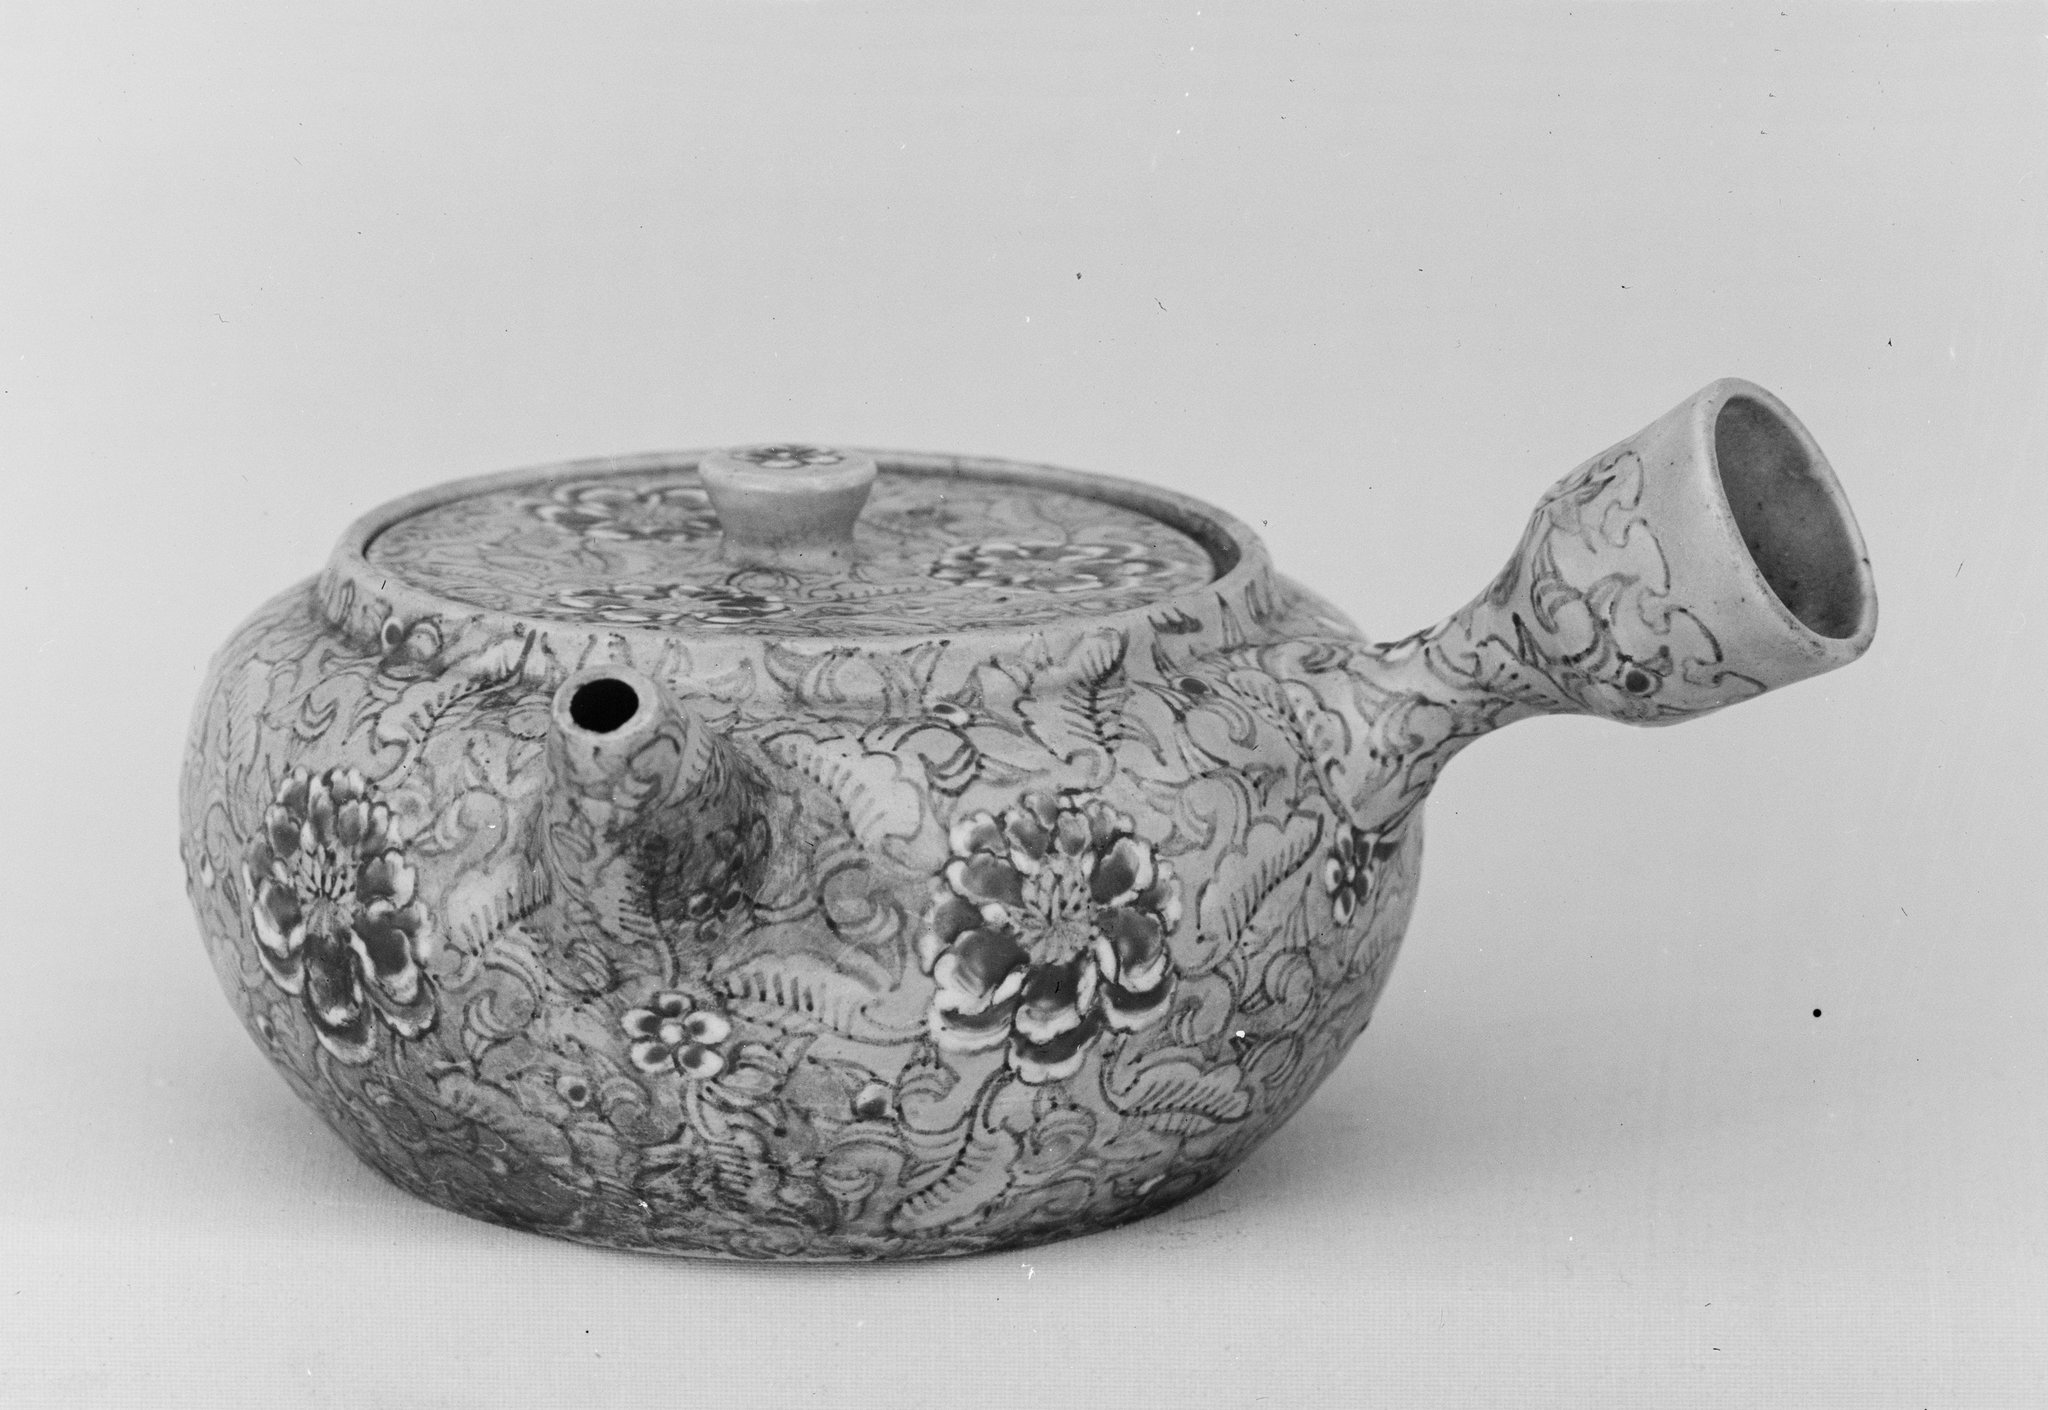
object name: teapot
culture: japanese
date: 1790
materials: enamel, pottery